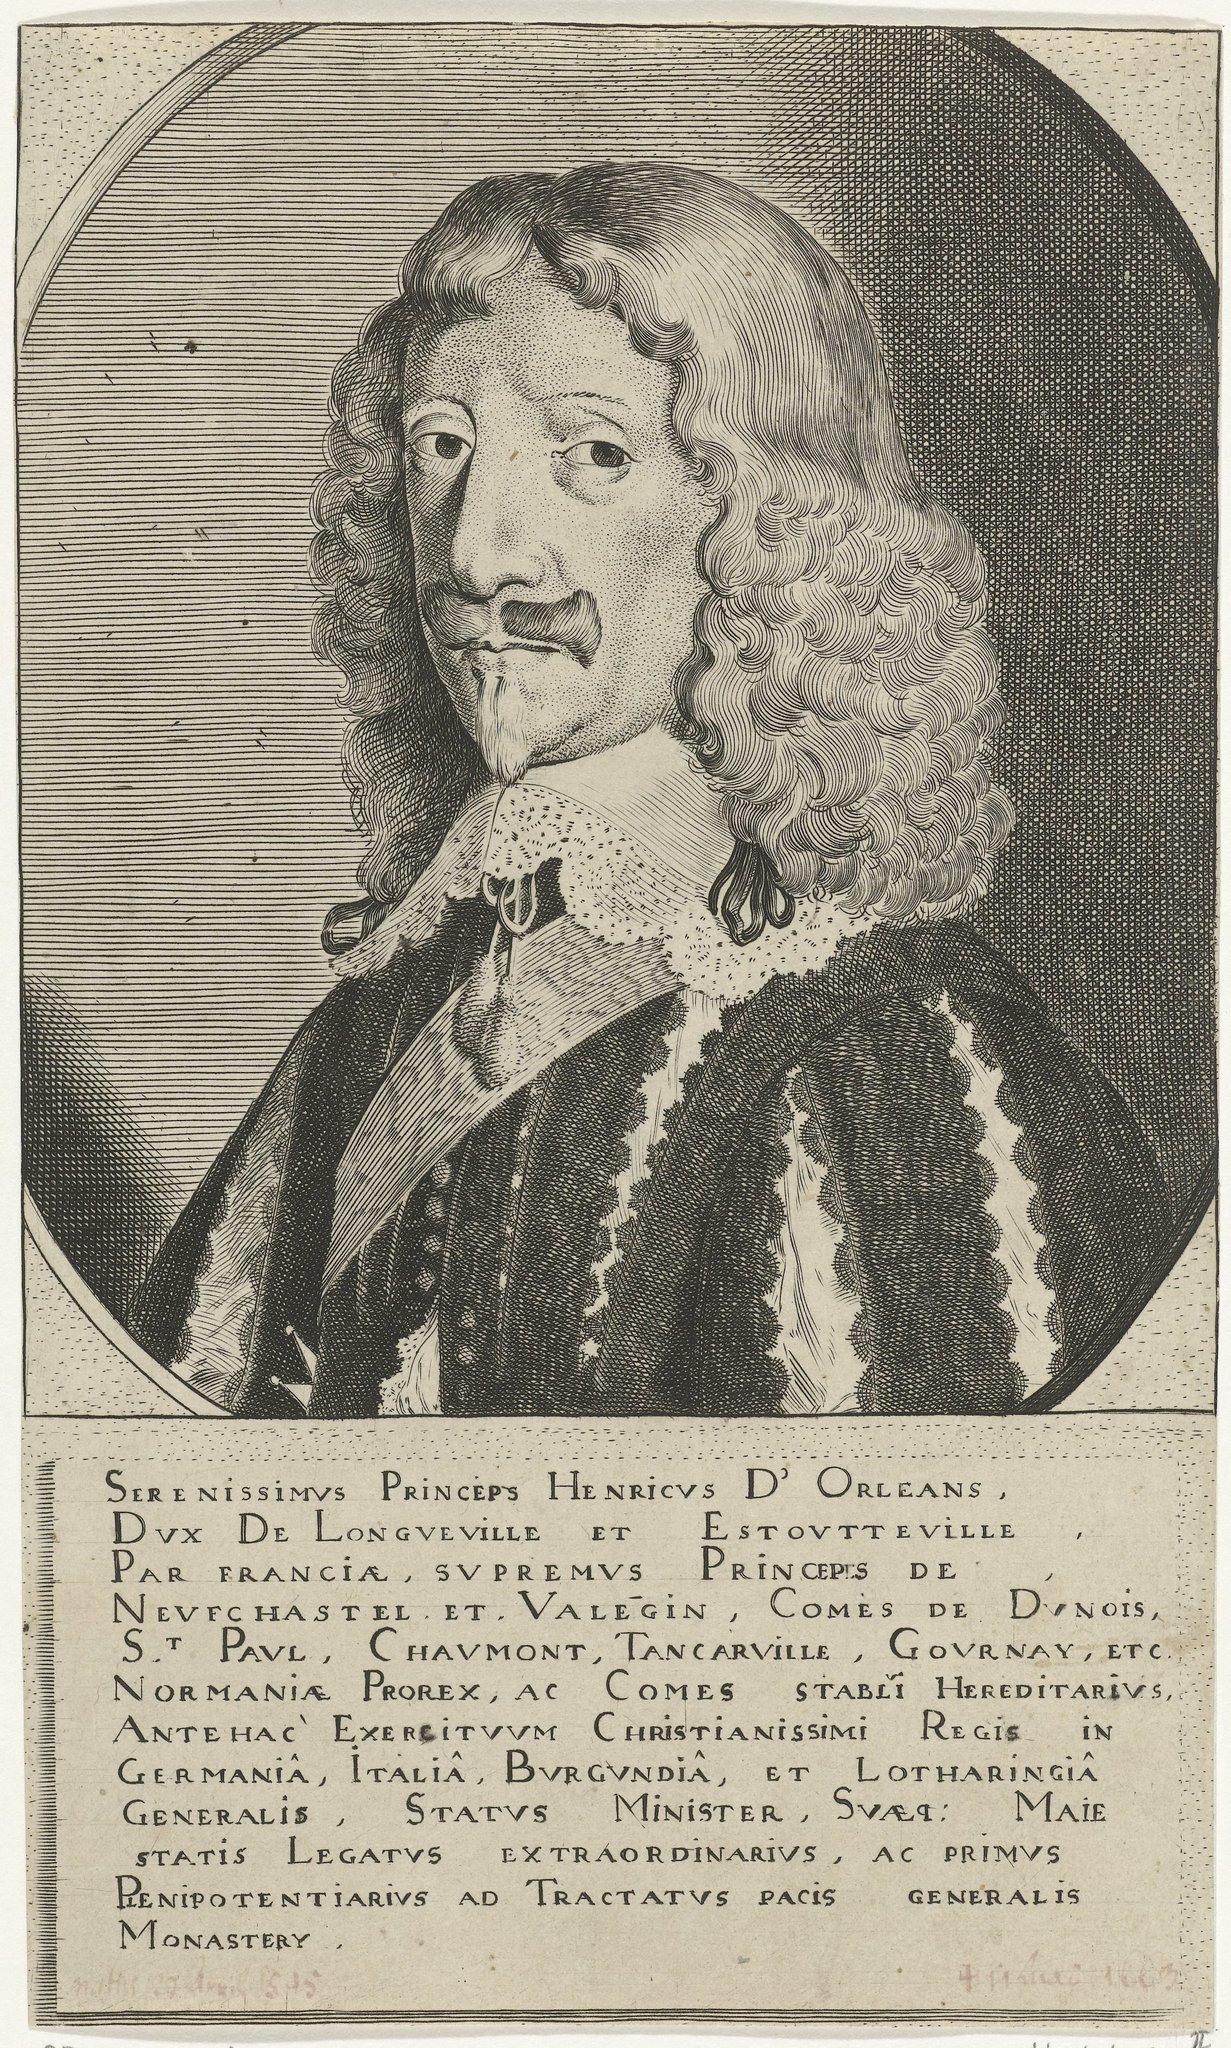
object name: print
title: Portret van Henri II d'Orléans, hertog van Longueville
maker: pieter holsteyn (ii)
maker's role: draughtsman, print maker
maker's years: 1614-1673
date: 1624-1663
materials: paper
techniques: engraving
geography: northern netherlands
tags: rouen, henri ii d'orléans (hertog van longueville)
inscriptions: collector's mark: Lugt 2228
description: Buste naar links van Henri II d'Orléans, hertog van Longueville. Onder het portret twaalf regels in het Latijn.